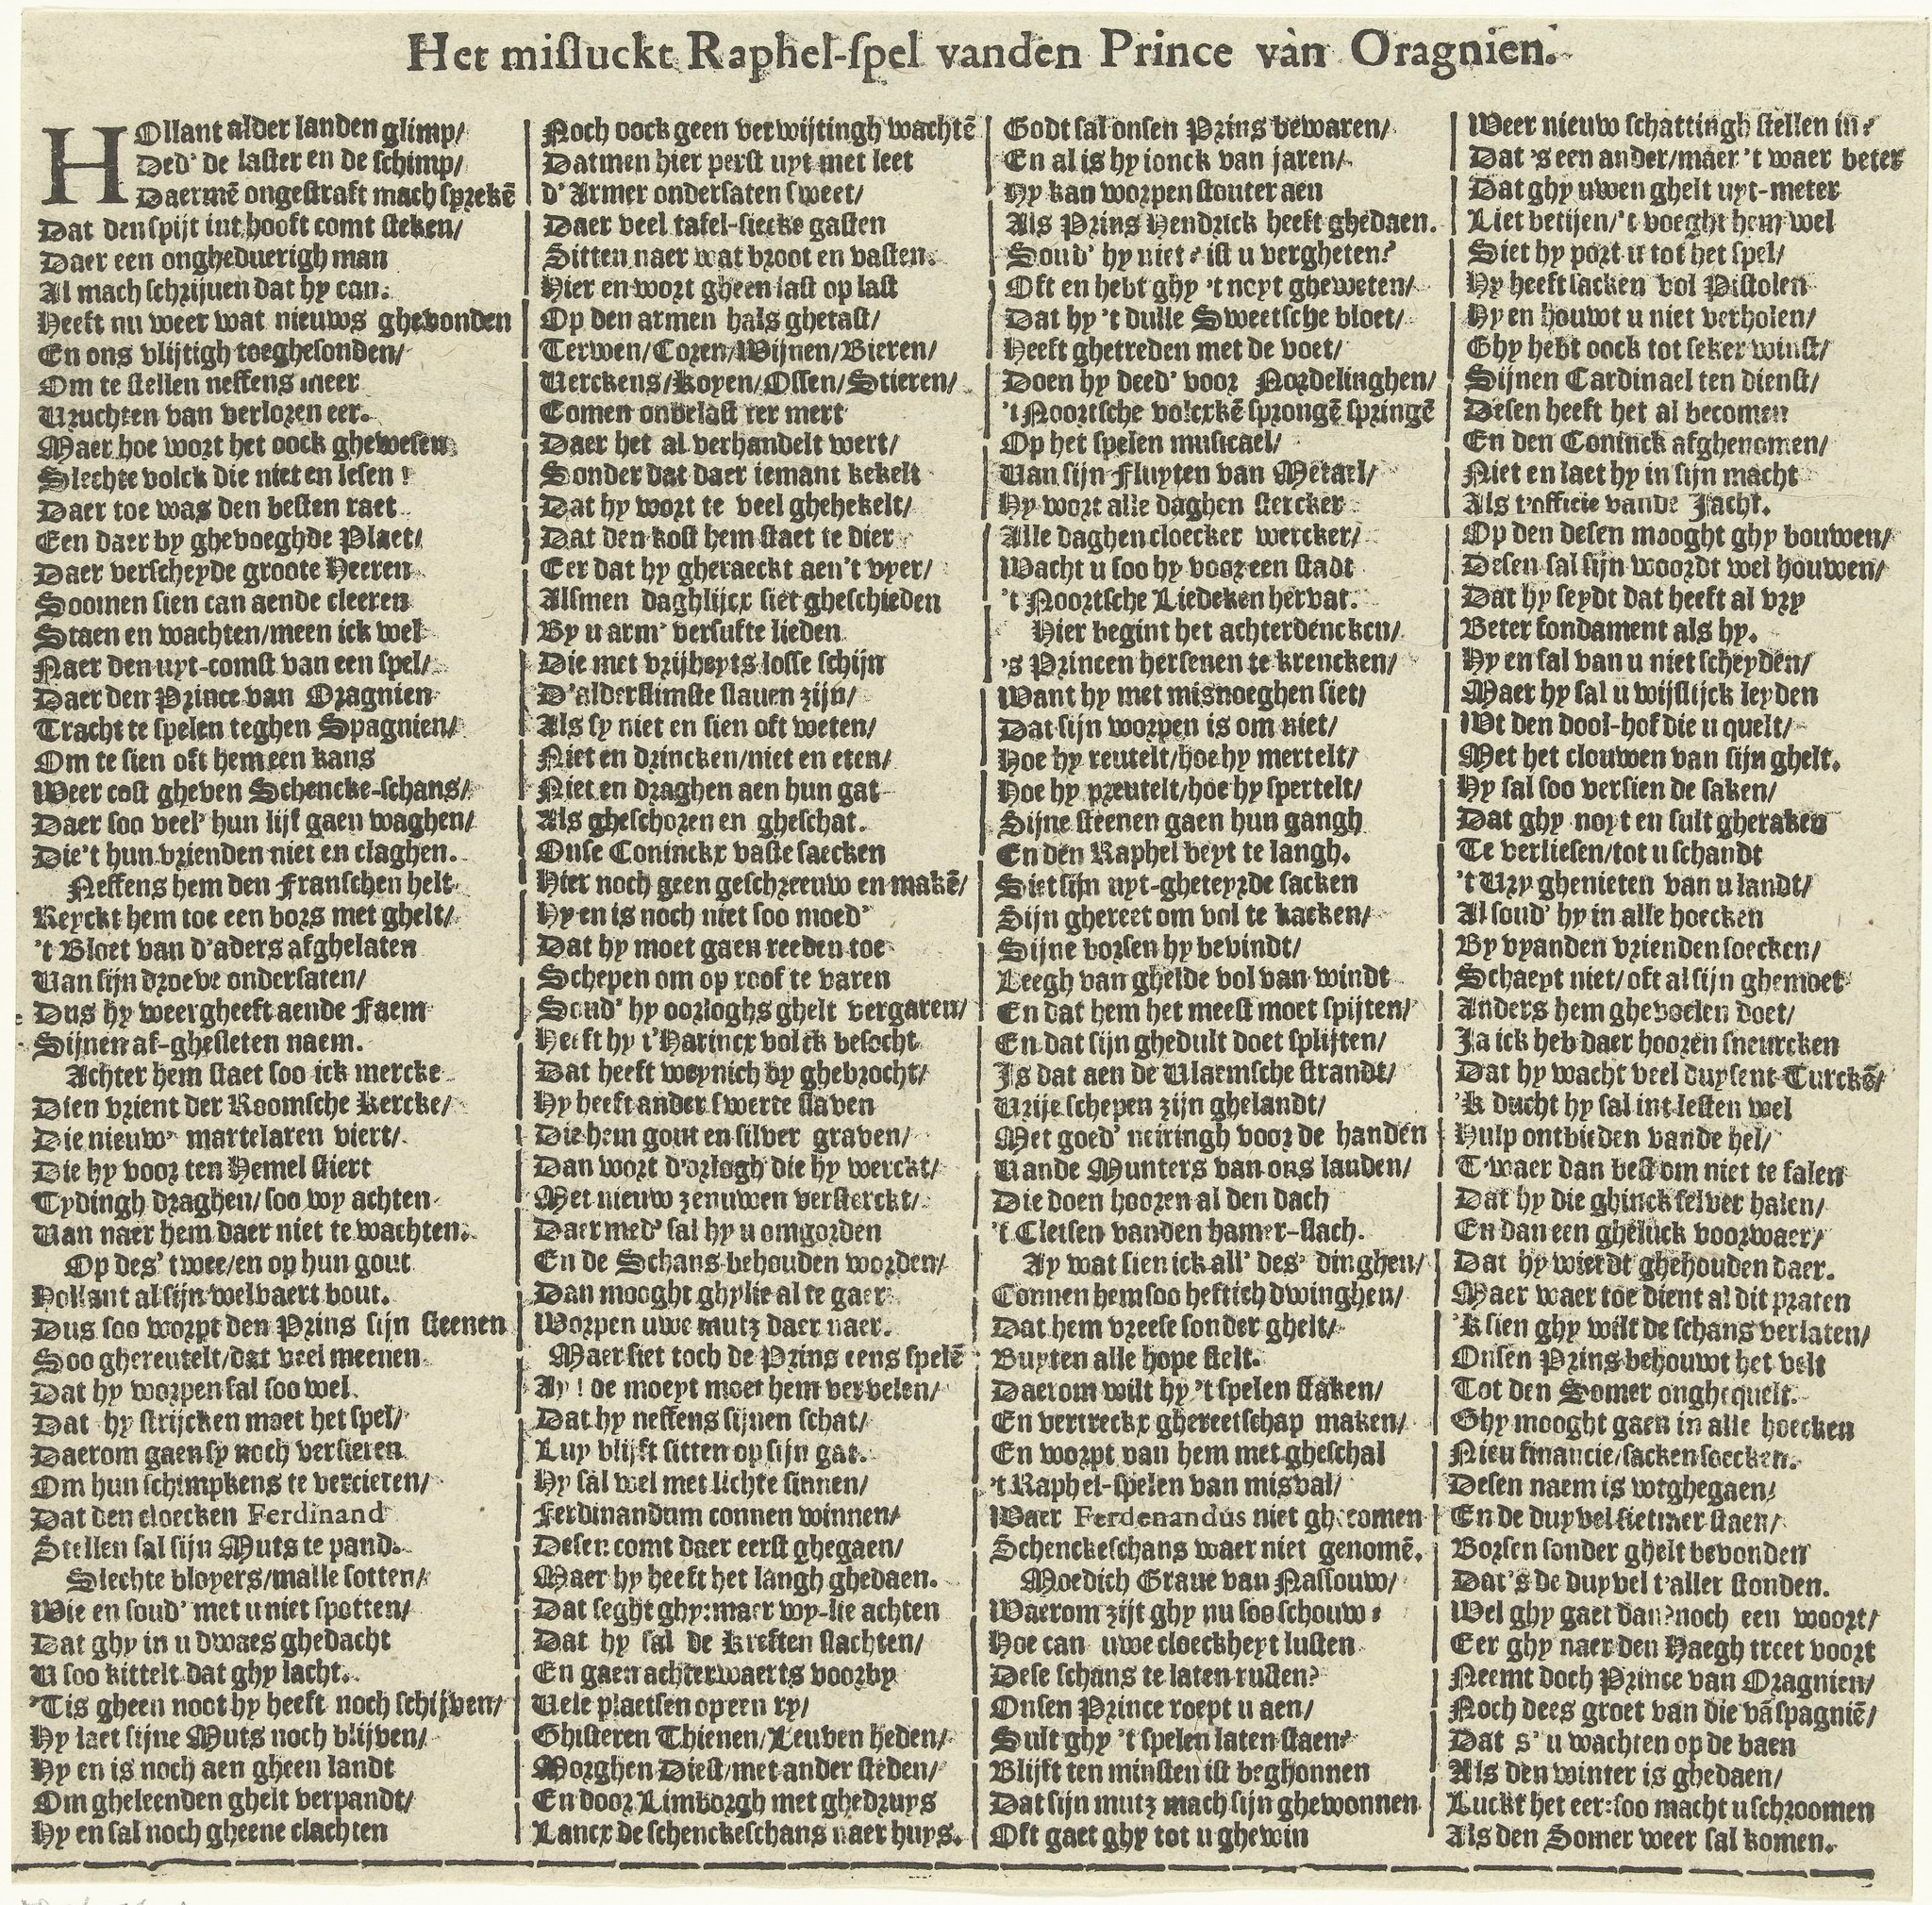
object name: text sheet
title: Het misluckt Raphel-spel vanden Prince van Oragnien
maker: Anonymous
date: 1635-1636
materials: paper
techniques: letterpress printing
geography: southern netherlands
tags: the hague, frederick henry (prince of orange), filips iv (koning van spanje), vienna, ferdinand ii (duits keizer), paris, armand-jean du plessis hertog van richelieu, brussels, landvoogd der zuidelijke nederlanden ferdinand van oostenrijk, lodewijk xiii (koning van frankrijk)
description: Het mislukte spel om Schenckenschans. Tekstblad bij de spotprent op de strijd om Schenckenschans in de jaren 1635-1636. Blad met 4 kolommen tekst in het Nederlands. Antwoord van Spaanse zijde op de prent beschreven onder FMH 1747.